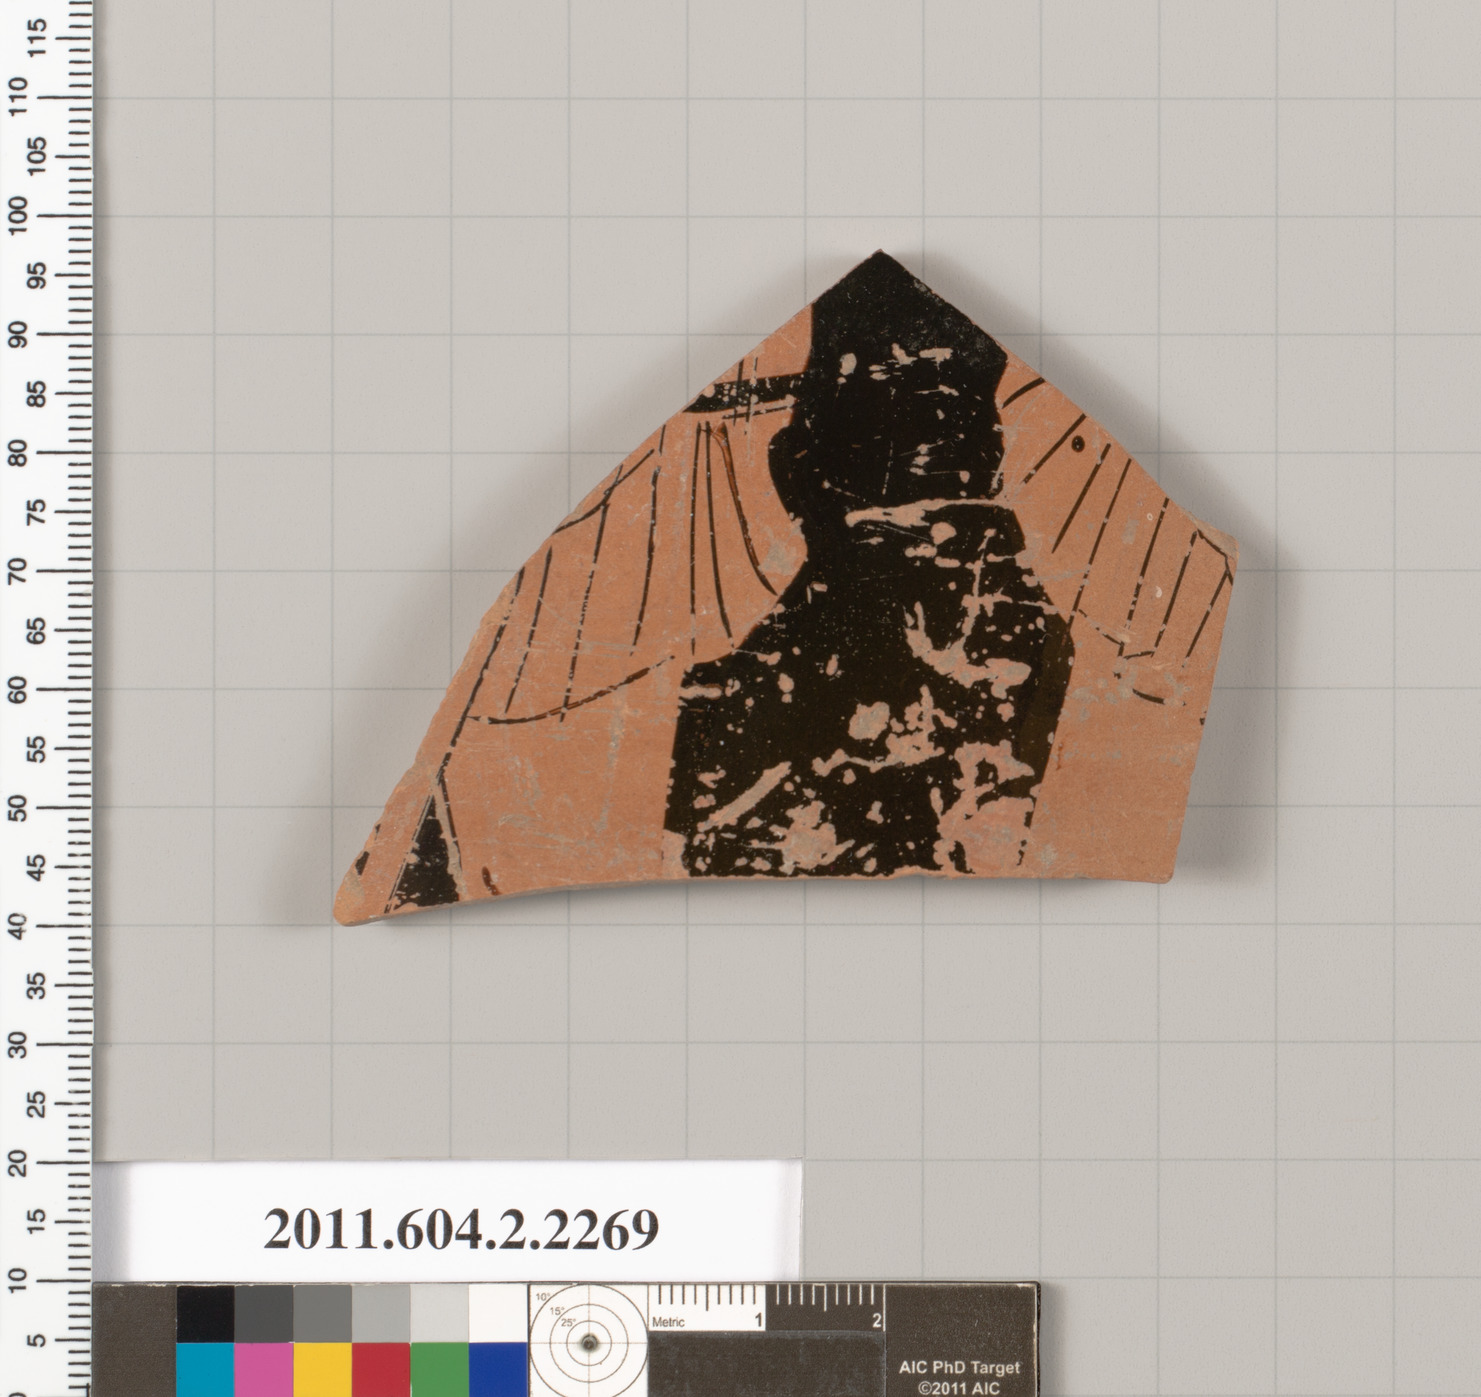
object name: krater fragment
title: Terracotta fragment of a krater (bowl for mixing wine and water)?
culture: greek, attic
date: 460-440 BCE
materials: terracotta